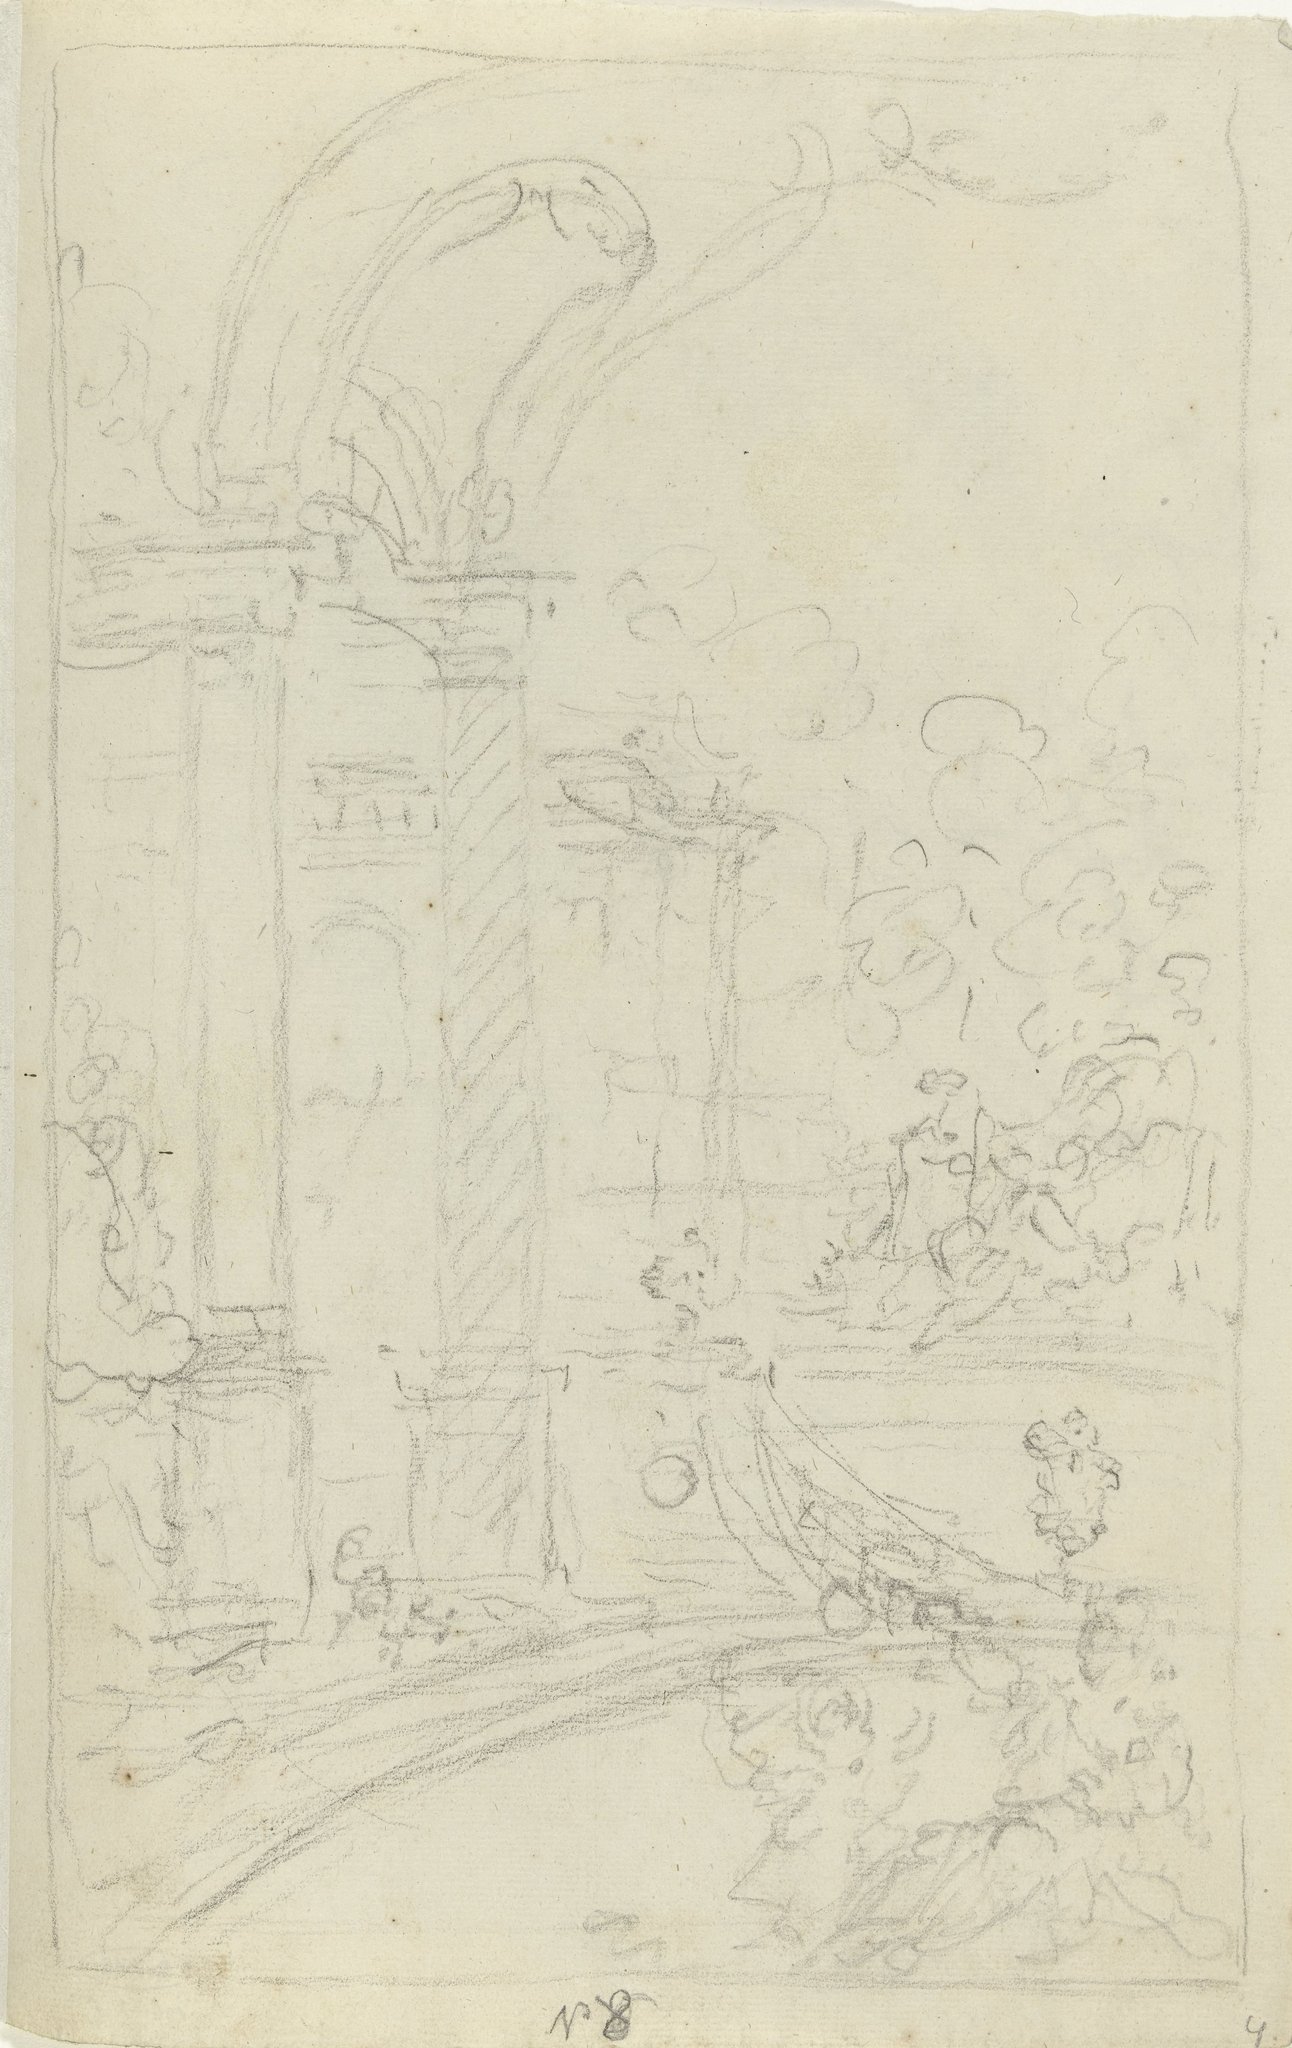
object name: drawing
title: Ontwerpschets van een tuin met gebouwen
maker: dionys van nijmegen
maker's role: draughtsman, painter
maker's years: 1705-1798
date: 1715-1798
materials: chalk, paper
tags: garden